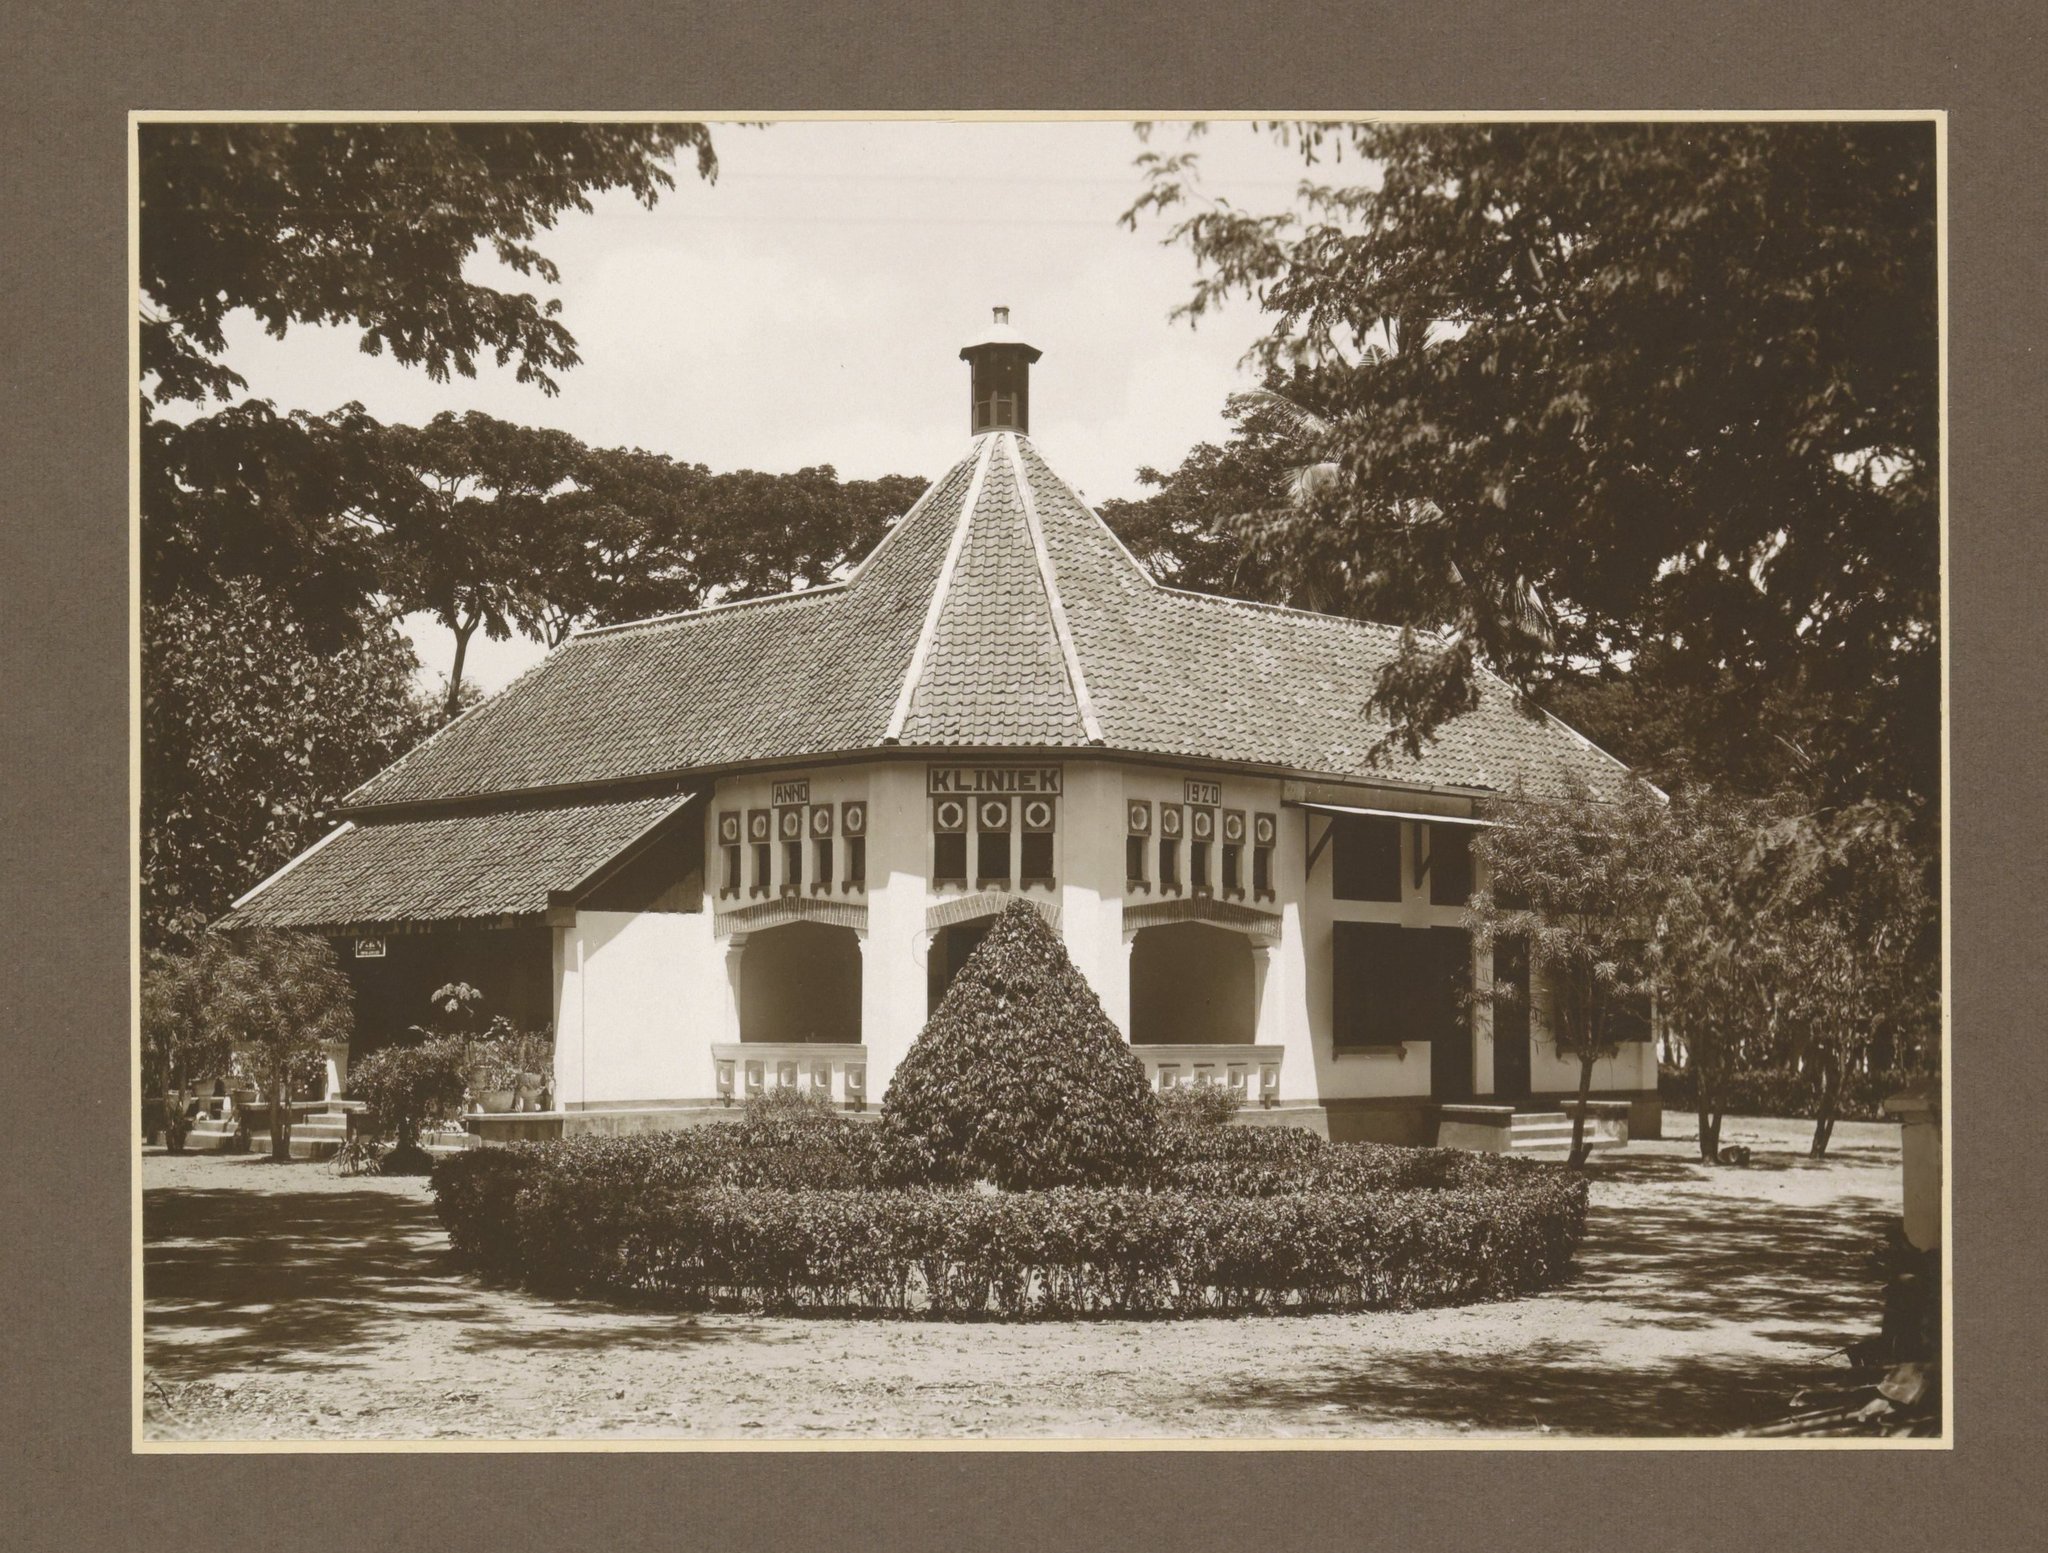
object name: photograph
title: Exterieur van de kliniek van suikerfabriek Ngandjoek op Java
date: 1925-1930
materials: cardboard, paper, photographic support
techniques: gelatin silver print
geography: nganjuk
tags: plantation, hospital, exterior ~ representation of a building, plants and herbs: sugarcane, sugar, dutch east indies, the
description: Onderdeel van Fotoalbum met opnames van vier suikerfabrieken op Java.